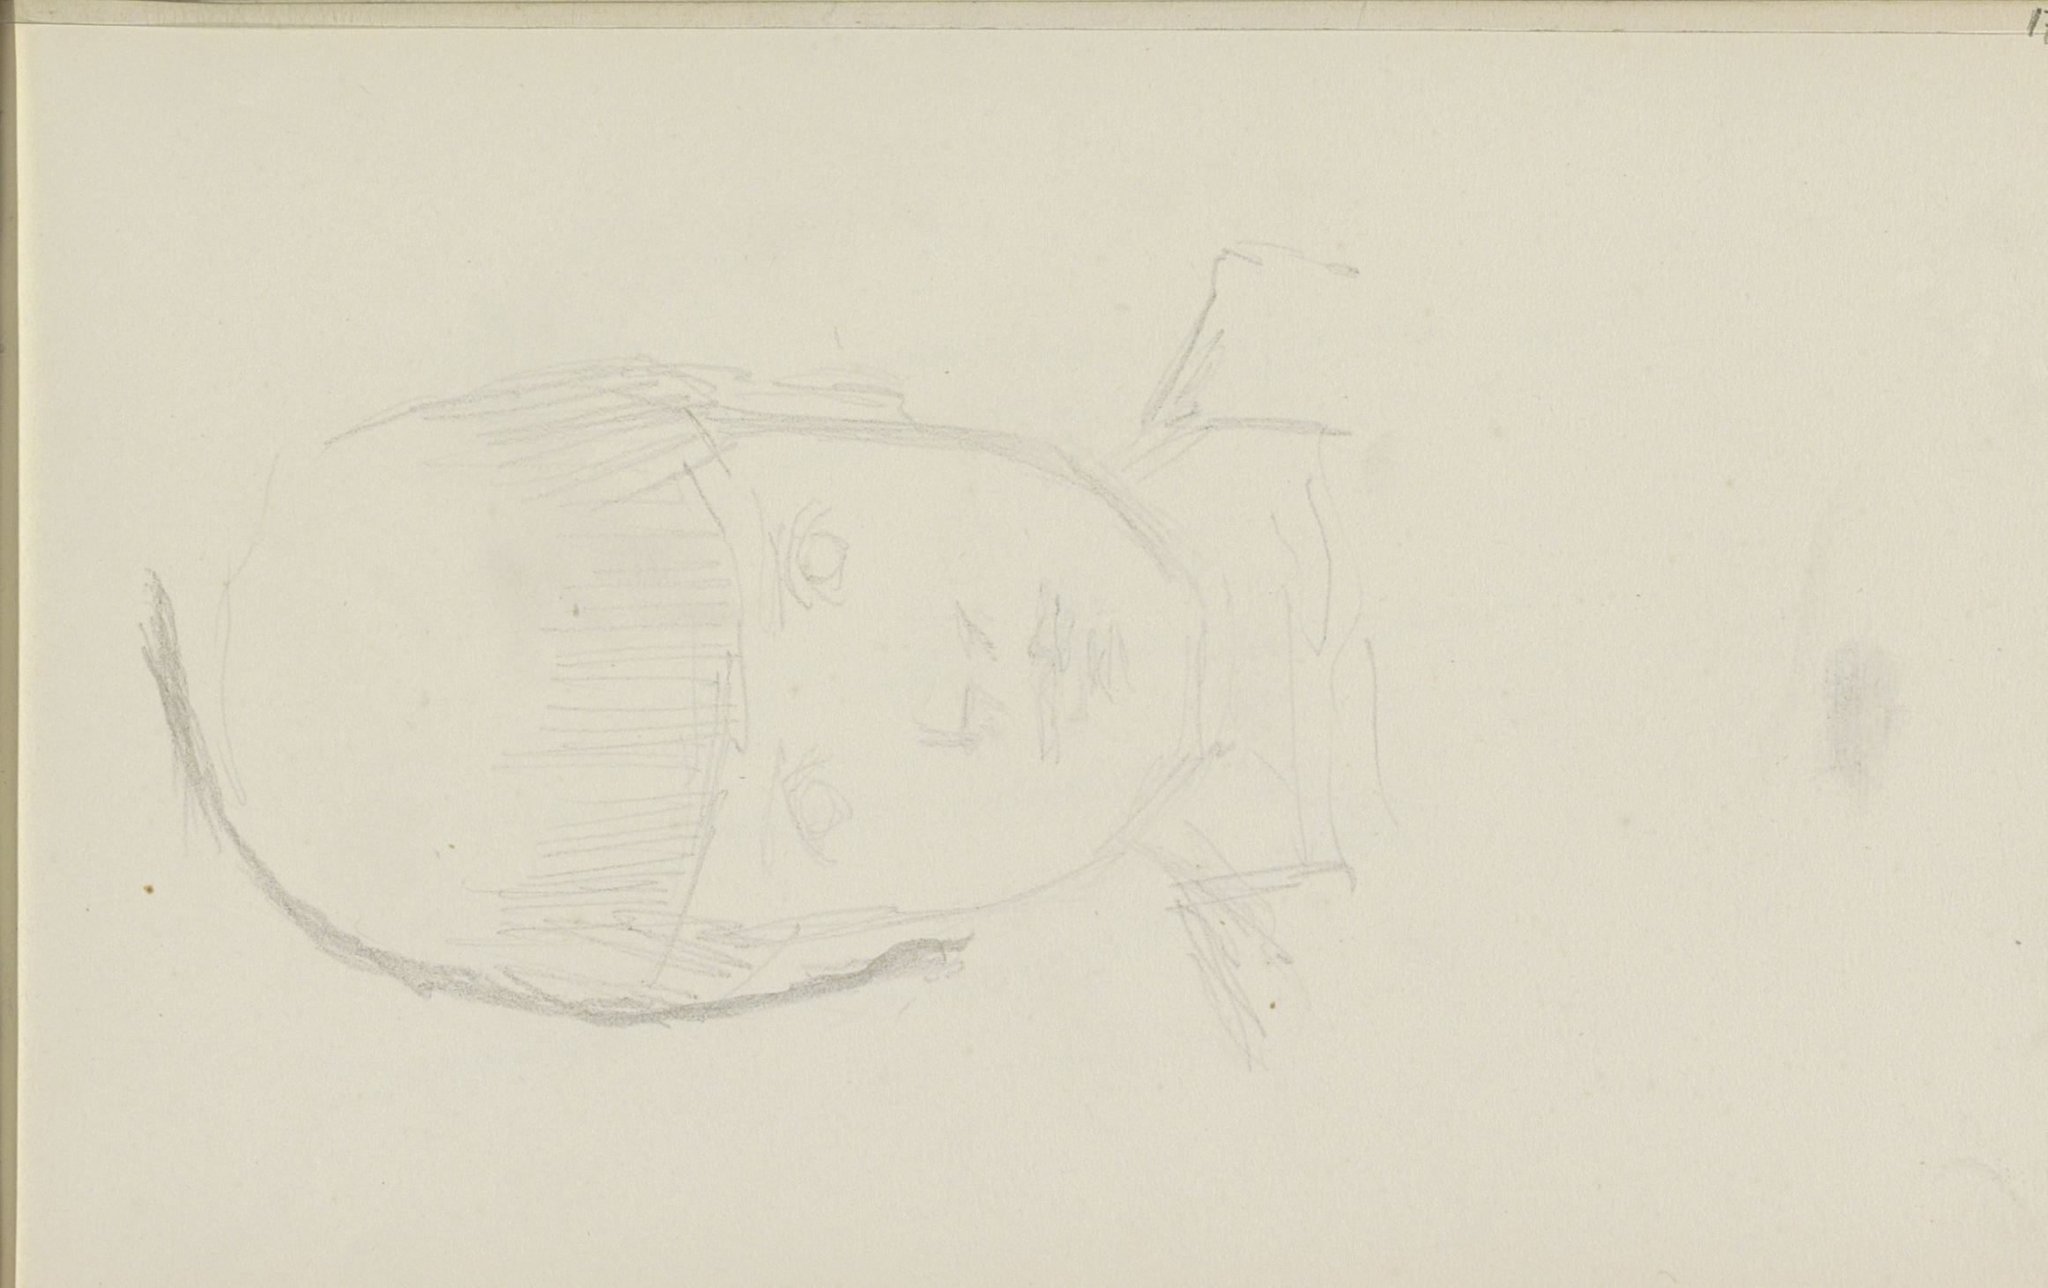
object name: sketchbook leaf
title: Kop van een kind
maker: jozef israëls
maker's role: draughtsman, painter, print maker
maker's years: 1824-1911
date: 1834-1911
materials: paper, pencil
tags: head (human), child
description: Blad 17 recto uit een schetsboek met 37 bladen.